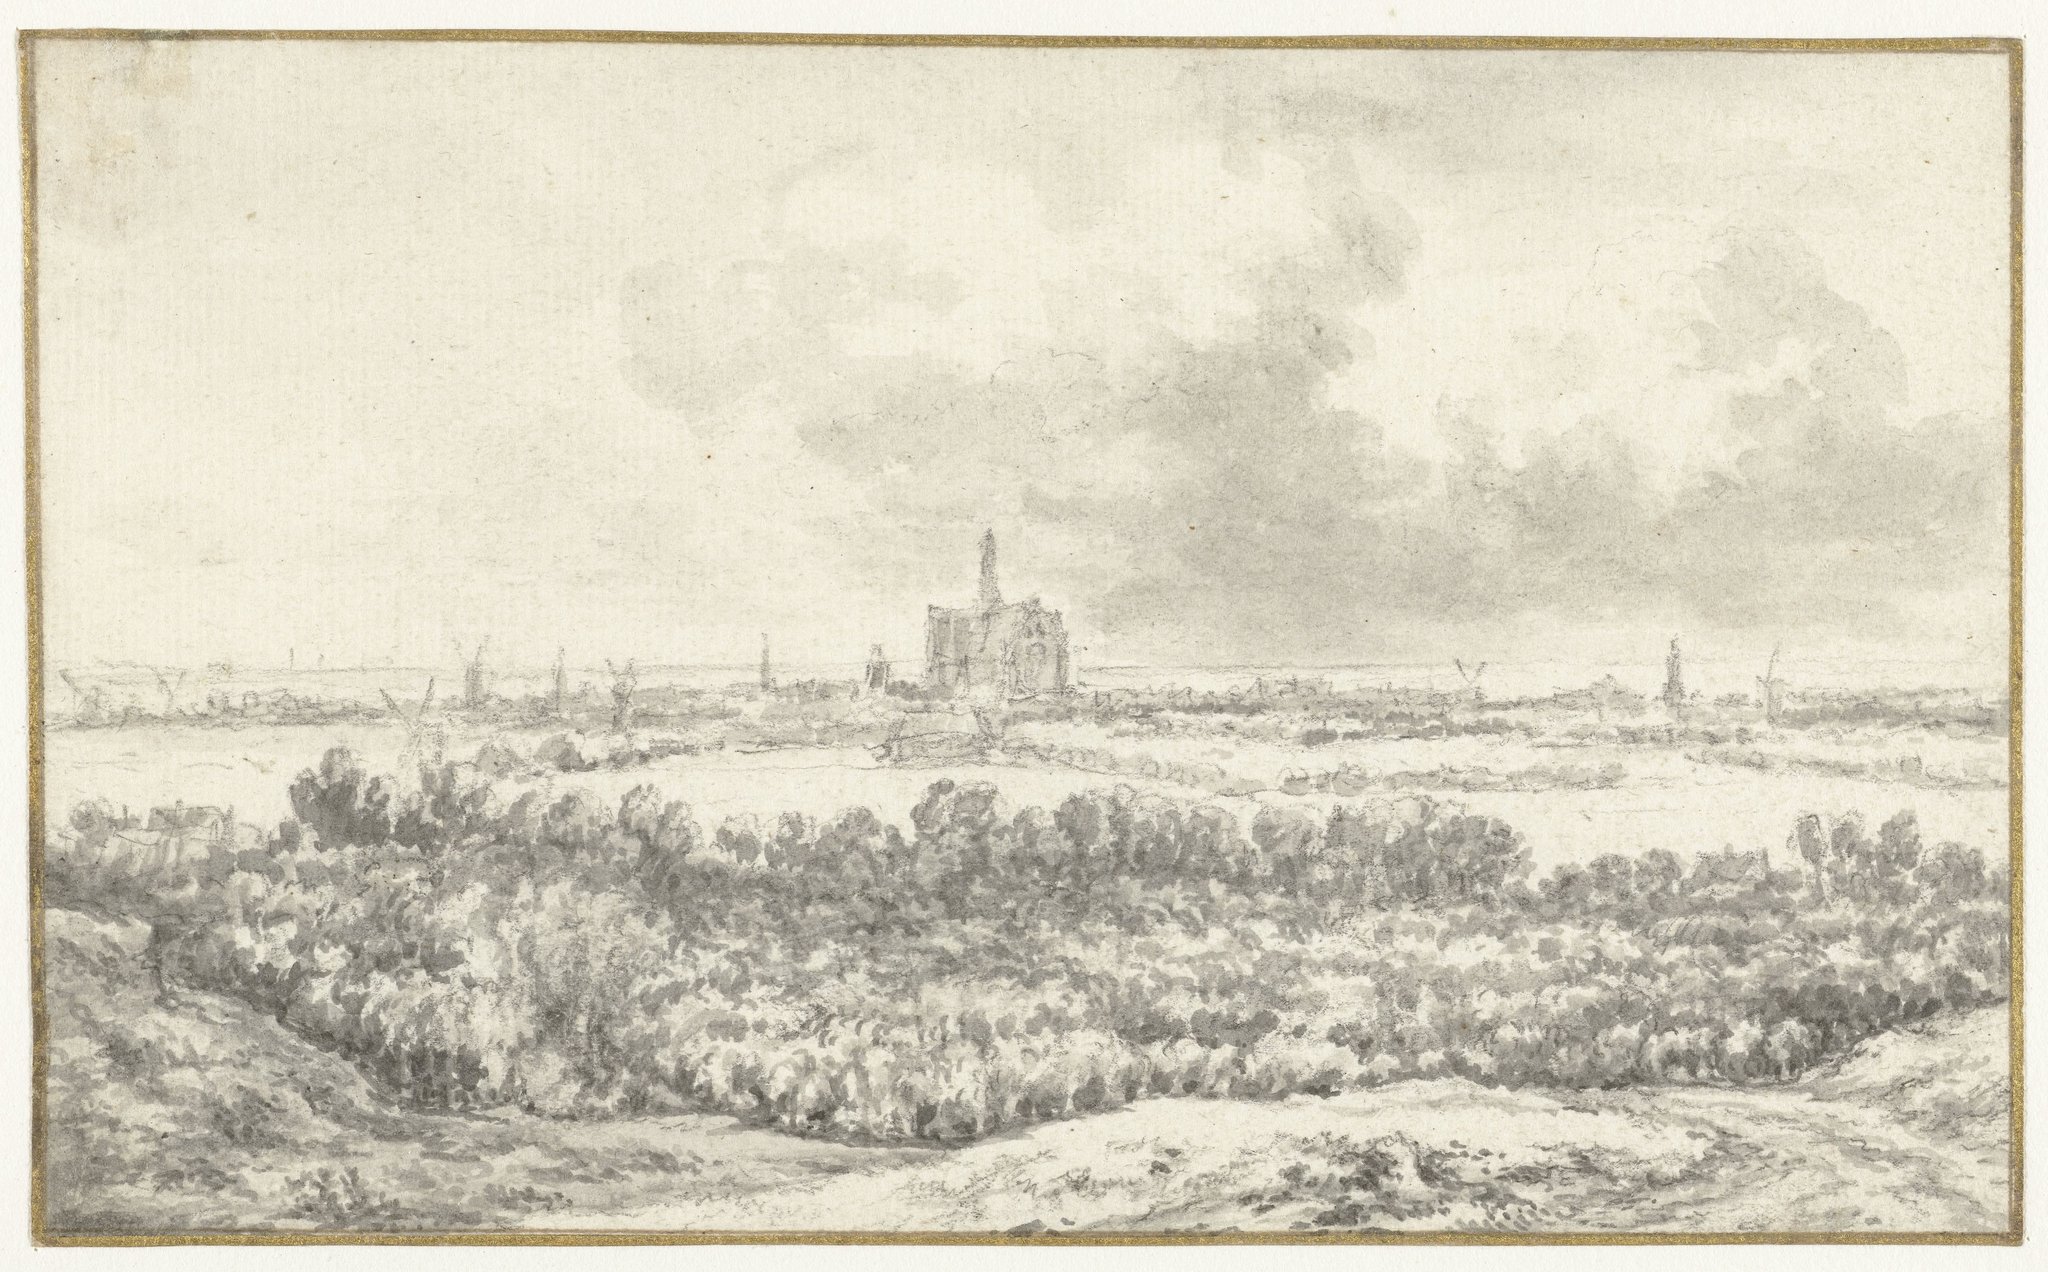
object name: drawing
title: Landscape with a View of Haarlem, Seen from the West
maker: jacob isaacksz van ruisdael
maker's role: draughtsman, painter, print maker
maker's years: 1628-1682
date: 1665-1675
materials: chalk, graphite, ink, paper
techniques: brush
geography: haarlem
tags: dunes (sea not visible); in the dunes, prospect of city, town panorama, silhouette of city, haarlem